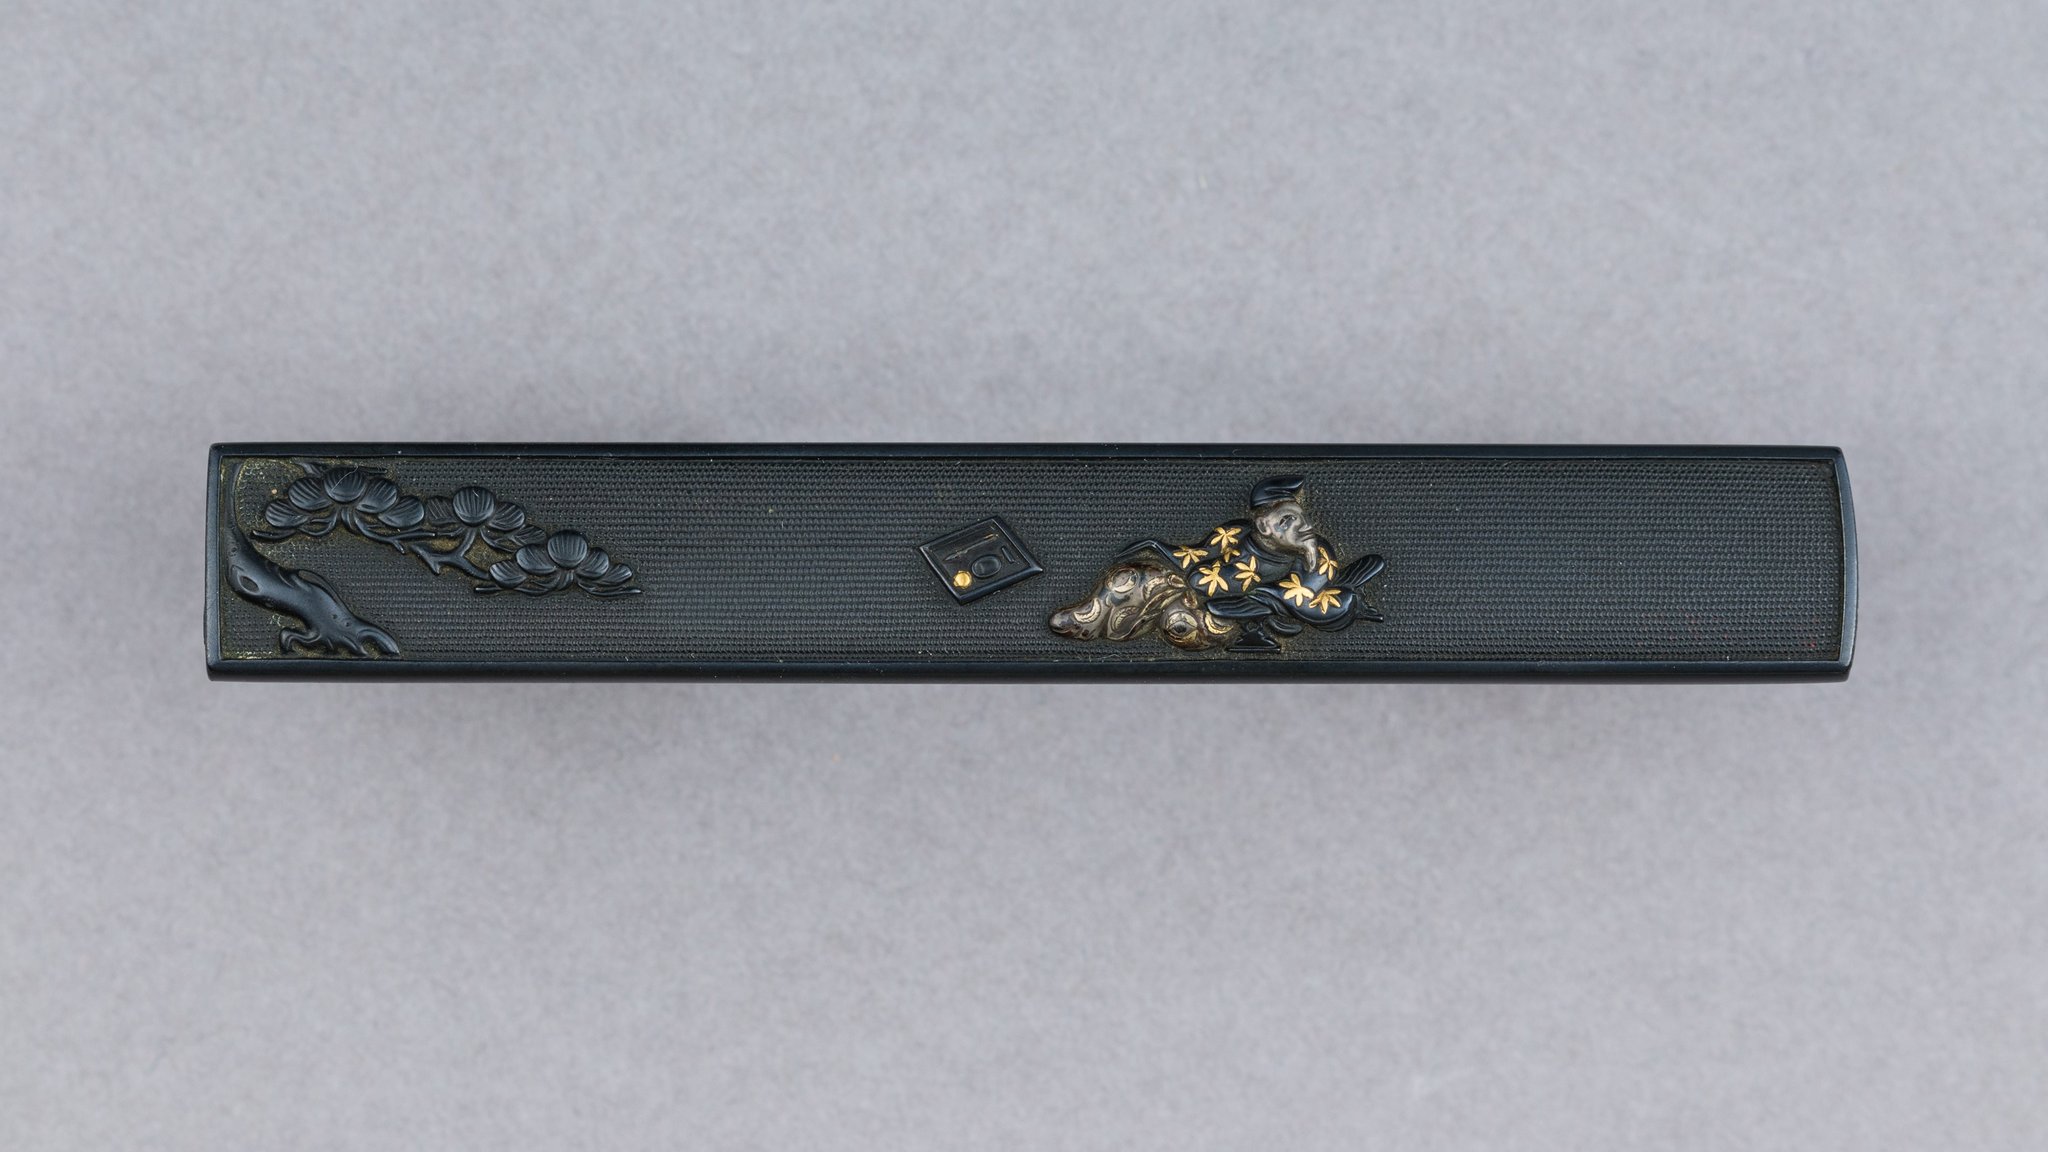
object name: knife handle kozuka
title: Knife Handle (Kozuka)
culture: japanese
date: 1601-1700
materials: gold alloy, gold, silver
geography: japan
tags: men